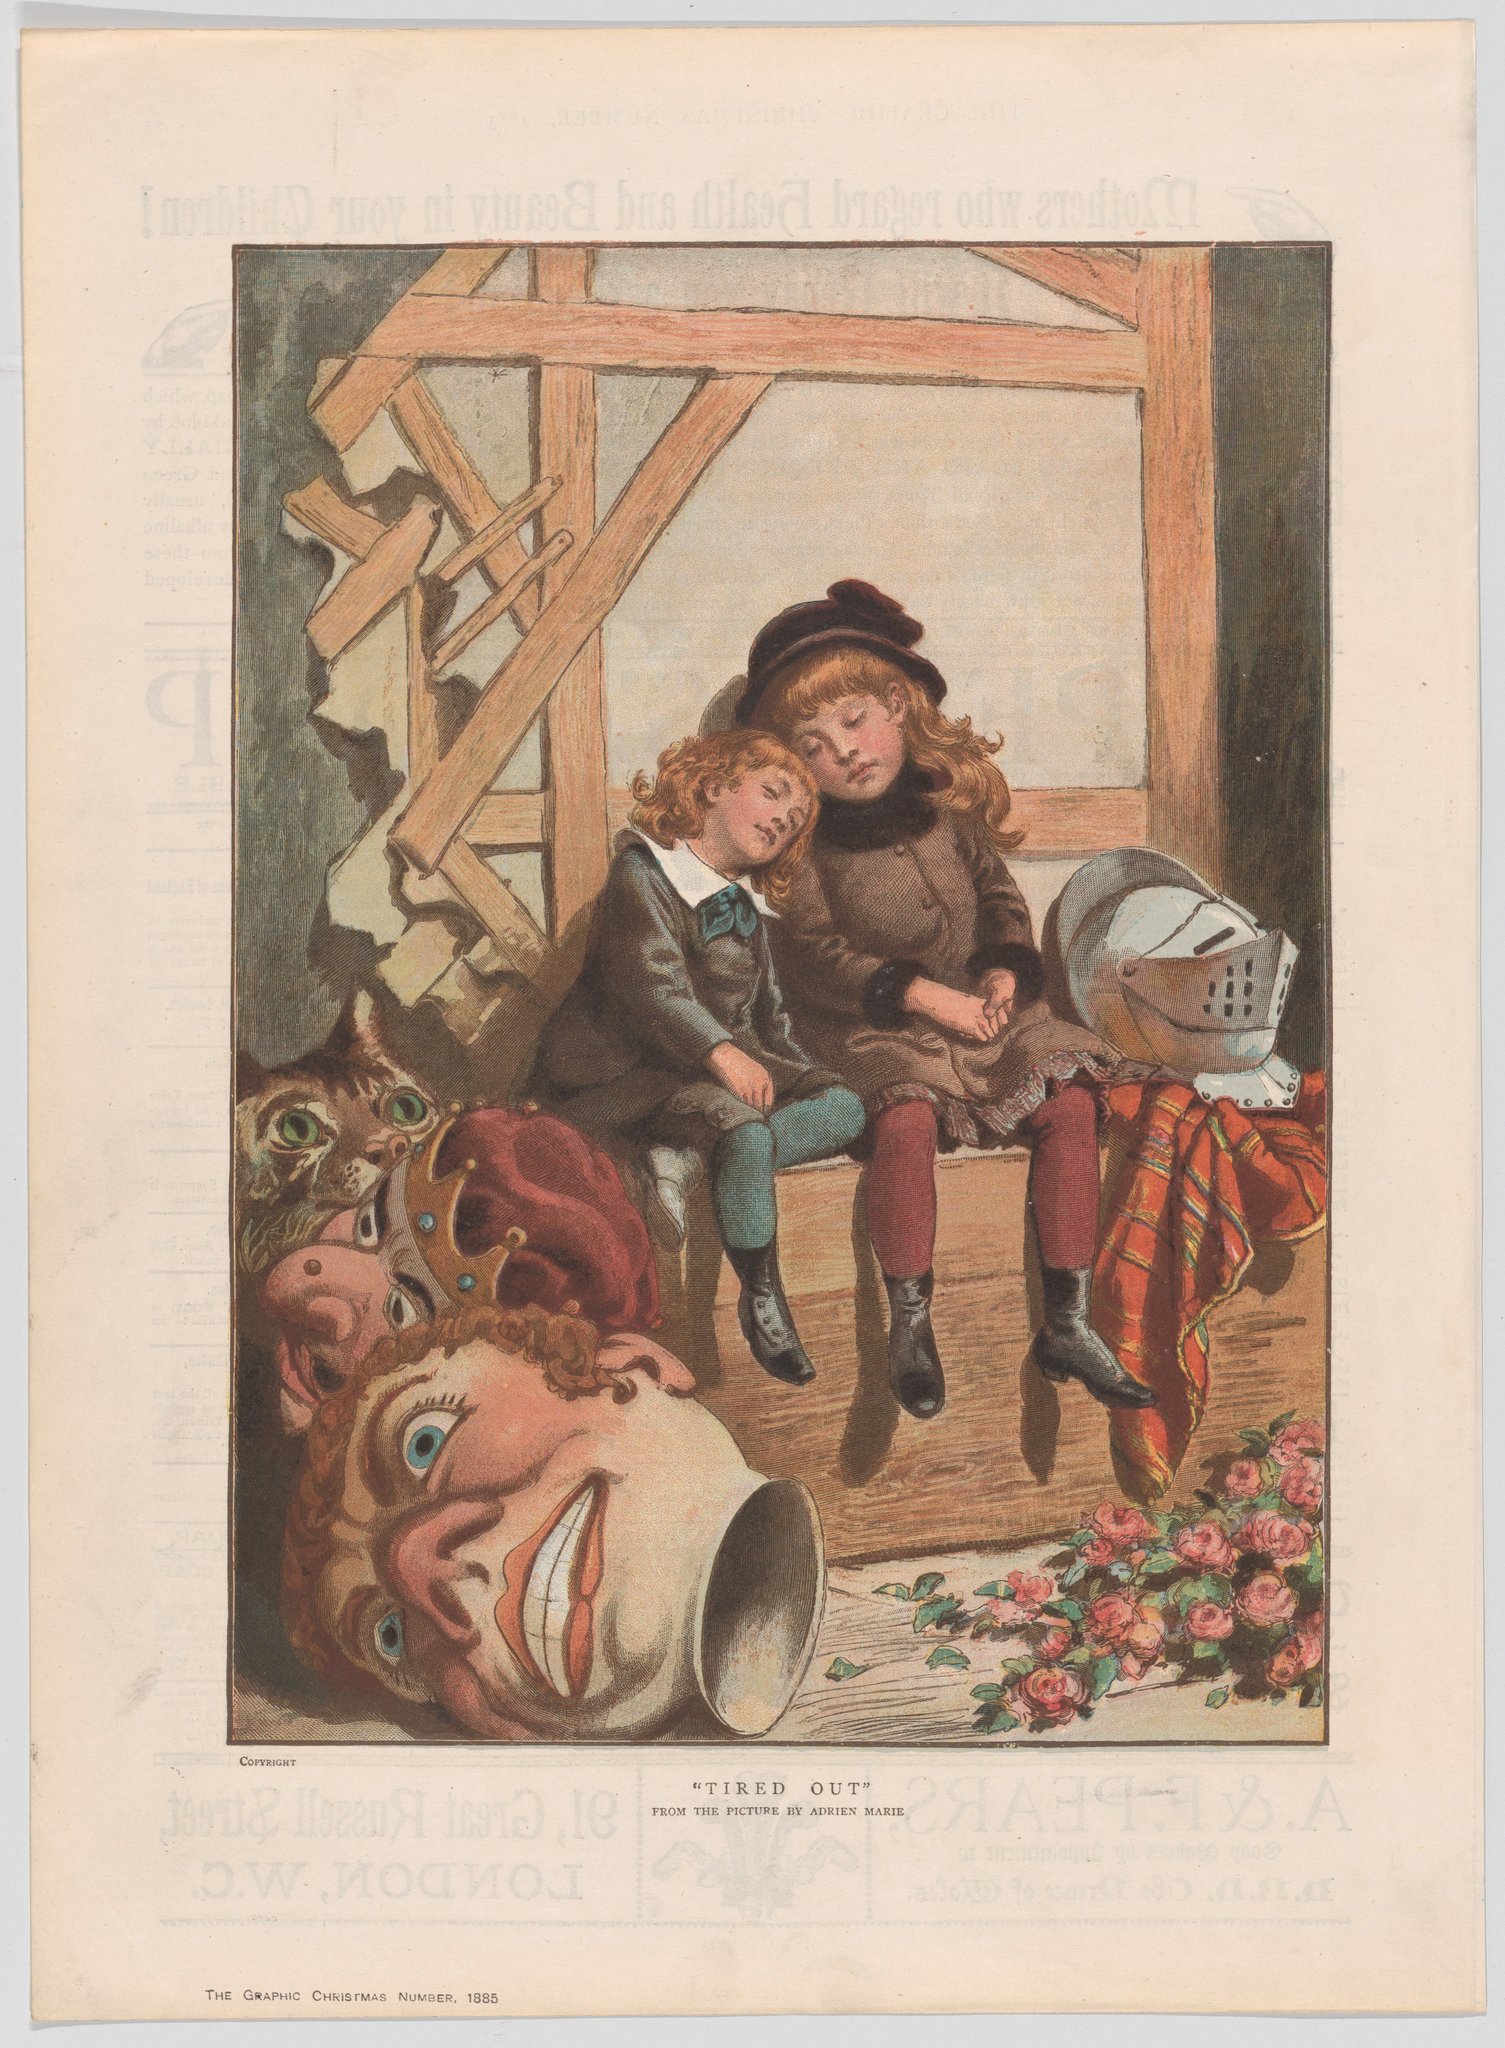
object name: print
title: Tired Out, from "The Graphic" Christmas Number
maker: adrien emmanuel marie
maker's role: draughtsman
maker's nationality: french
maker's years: 1848-1891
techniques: engraving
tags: masks,sleeping,girls